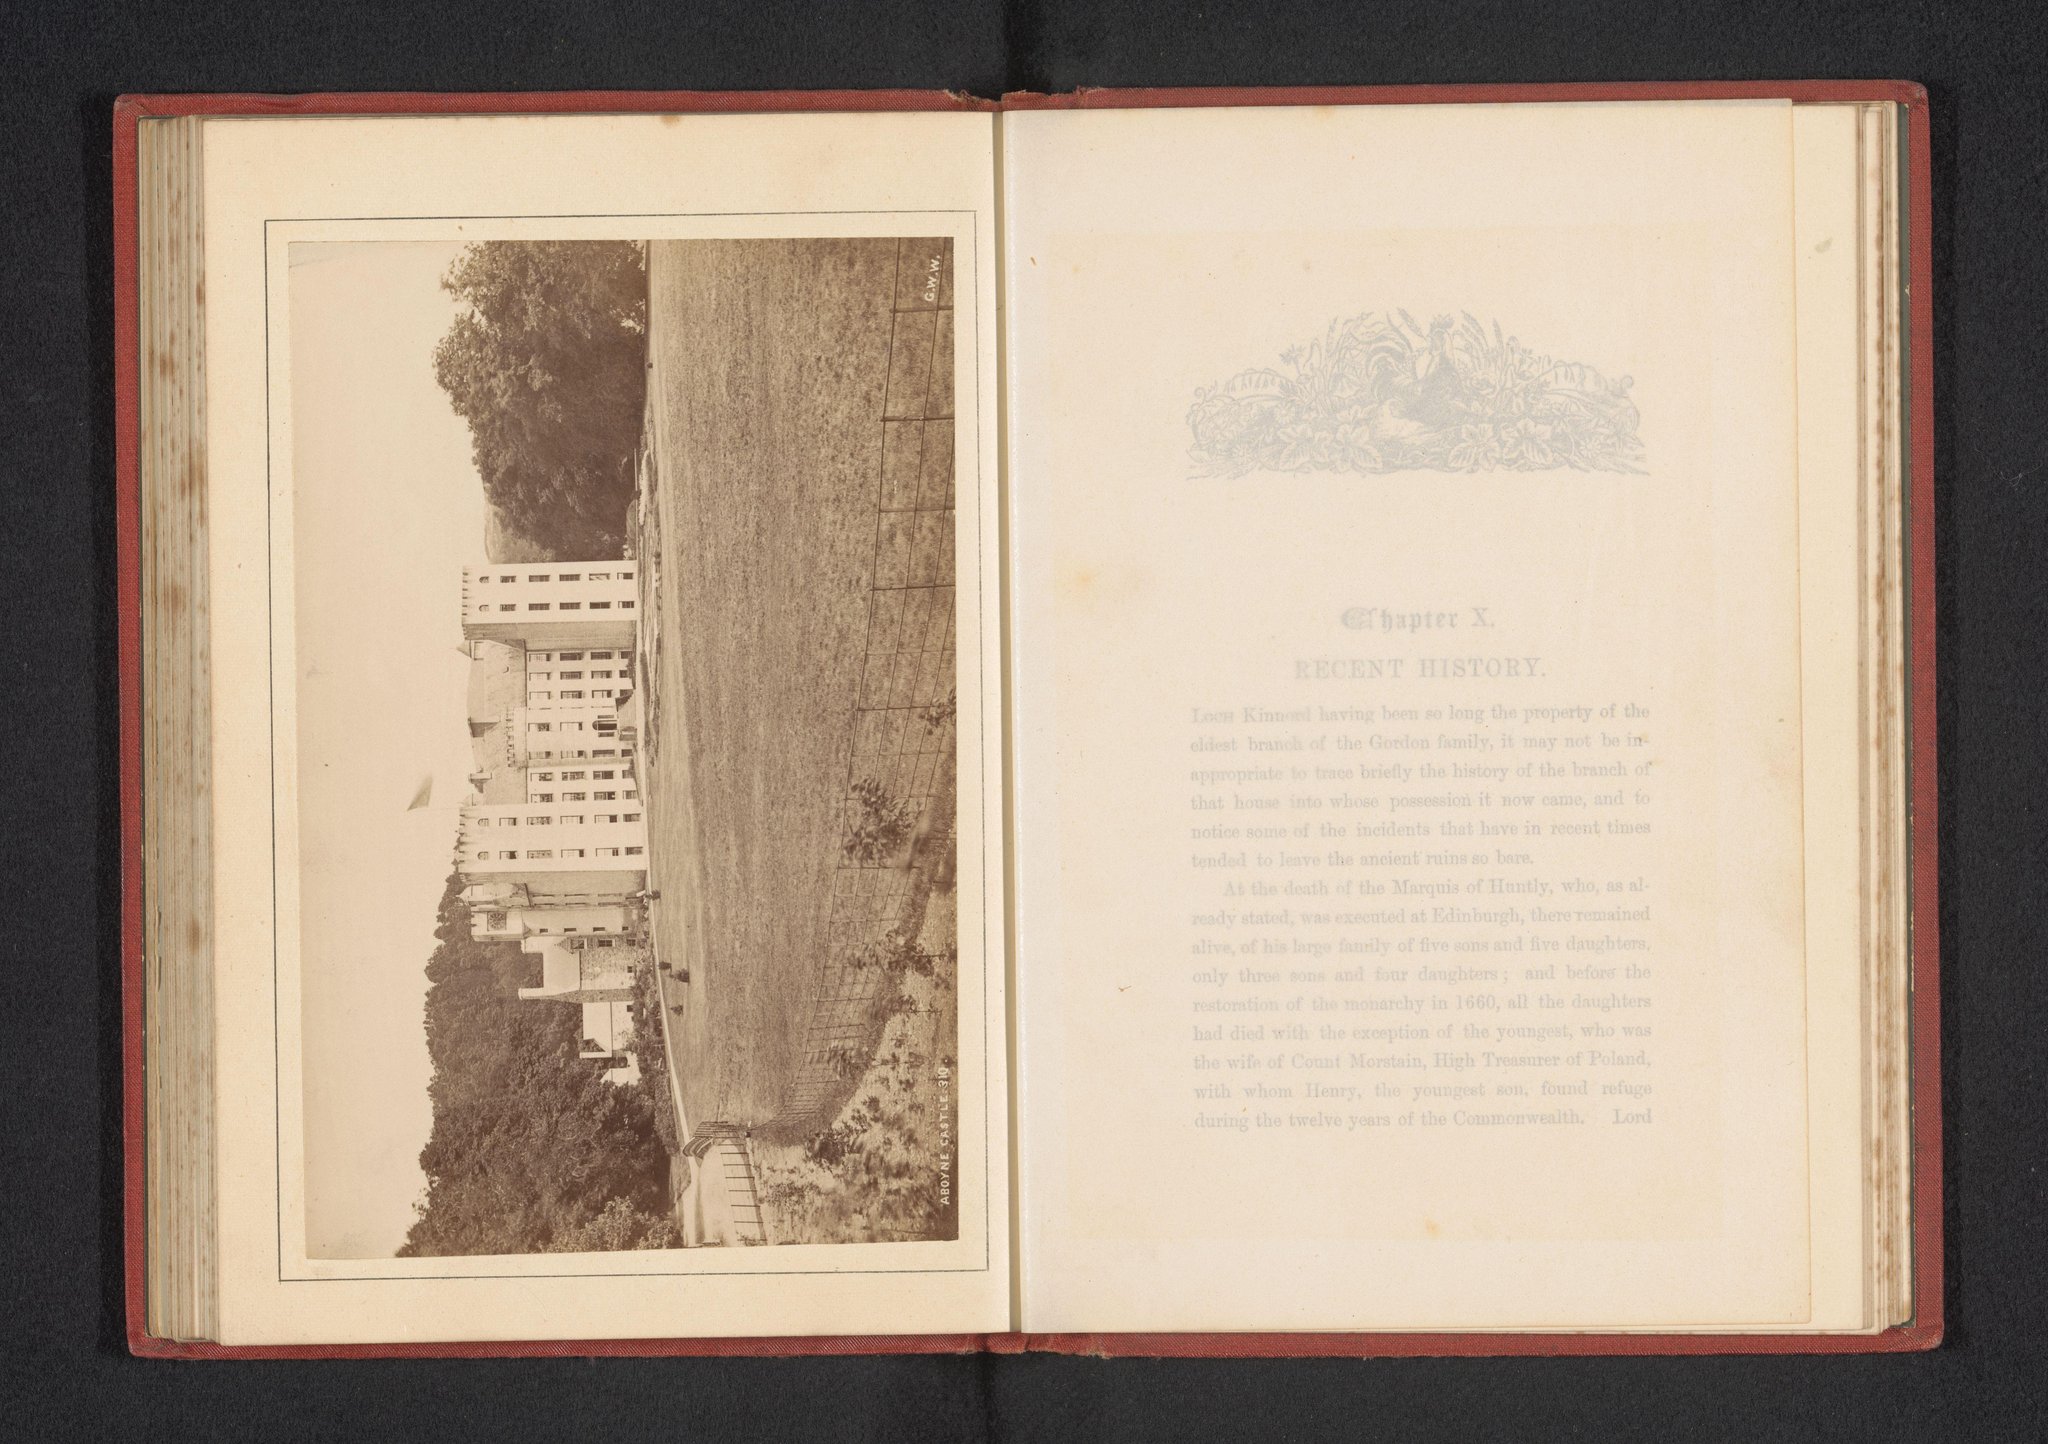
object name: page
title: Aboyne Castle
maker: george washington wilson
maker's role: publisher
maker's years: 1823-1893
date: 1872-1877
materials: photographic support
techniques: albumen print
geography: aboyne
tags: landscapes, castle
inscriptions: number: ‘310’, initials: ‘G.W.W.’